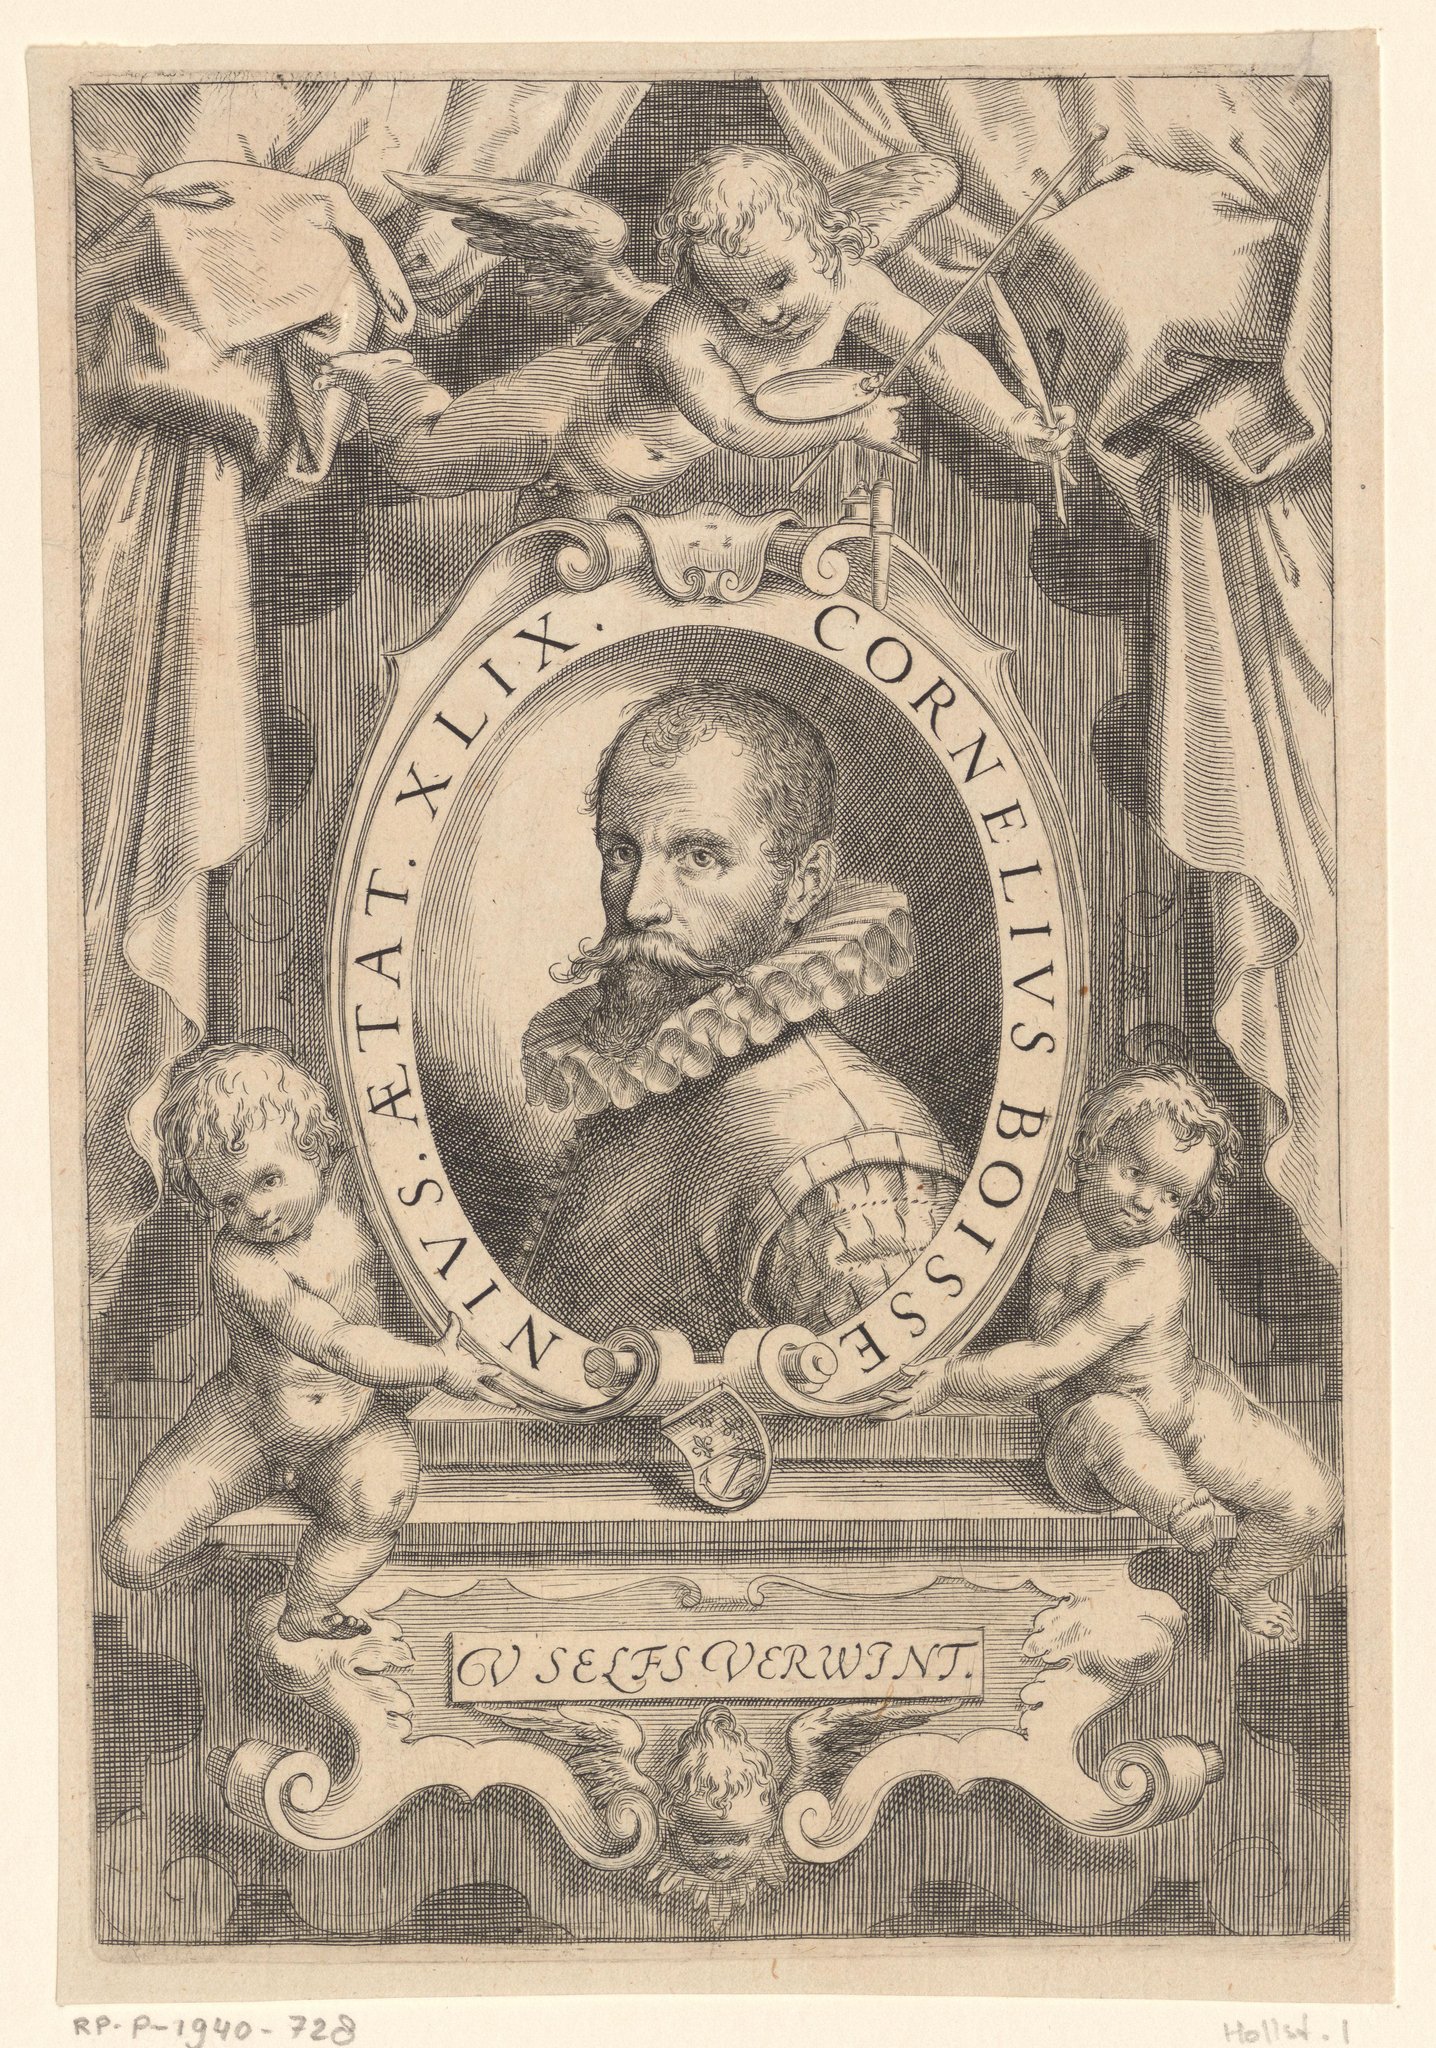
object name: print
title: Zelfportret op 49-jarige leeftijd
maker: cornelis dircksz. boissens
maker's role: draughtsman, print maker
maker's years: 1567-1635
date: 1616-1617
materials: paper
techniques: engraving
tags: enkhuizen, leiden, print maker, draughtsman, cornelis dircksz. boissens, historical persons, portrait, self-portrait of artist, cupids: 'amores', 'amoretti', 'putti', armorial bearing, heraldry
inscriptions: collector's mark: Lugt 2228, collector's mark: Lugt 2760